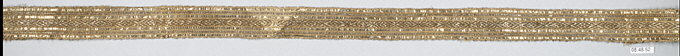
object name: galloon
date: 1601-1800